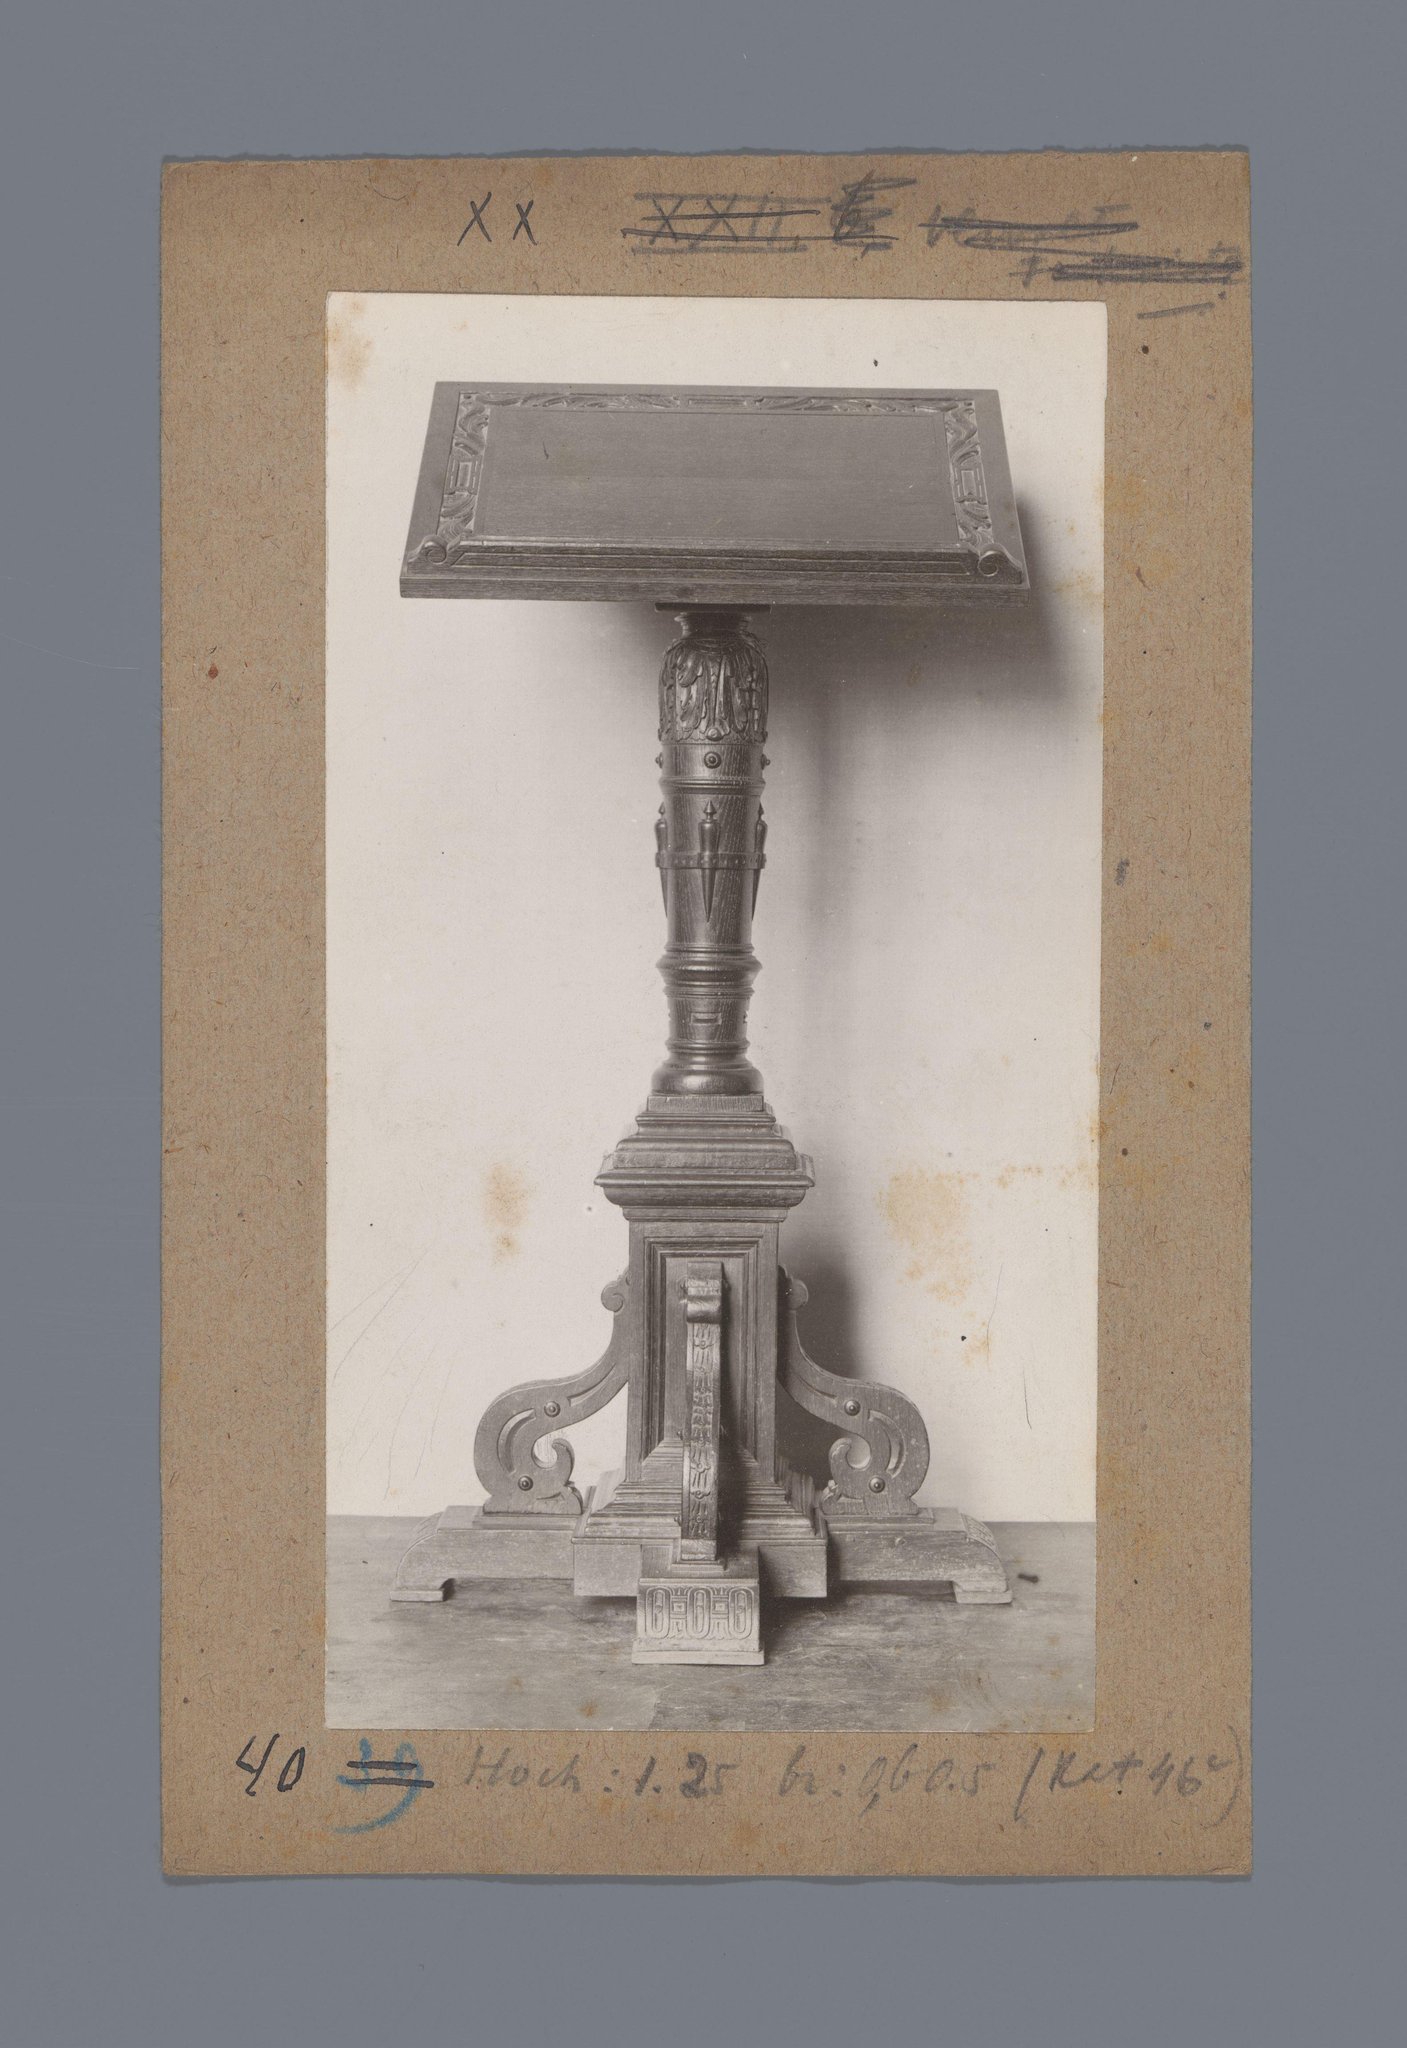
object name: photograph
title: Tafel (vermoedelijk) in het Rijksmuseum te Amsterdam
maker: Anonymous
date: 1875-1900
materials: photographic support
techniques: matte daylight collodion silver print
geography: amsterdam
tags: table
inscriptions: number: ‘XX 40 (Kat 46 c)’, collector's mark: ‘Instituut voor kunst-nijverheidsonderwijs Gabriël Metsustraat No. 16, Amsterdam’